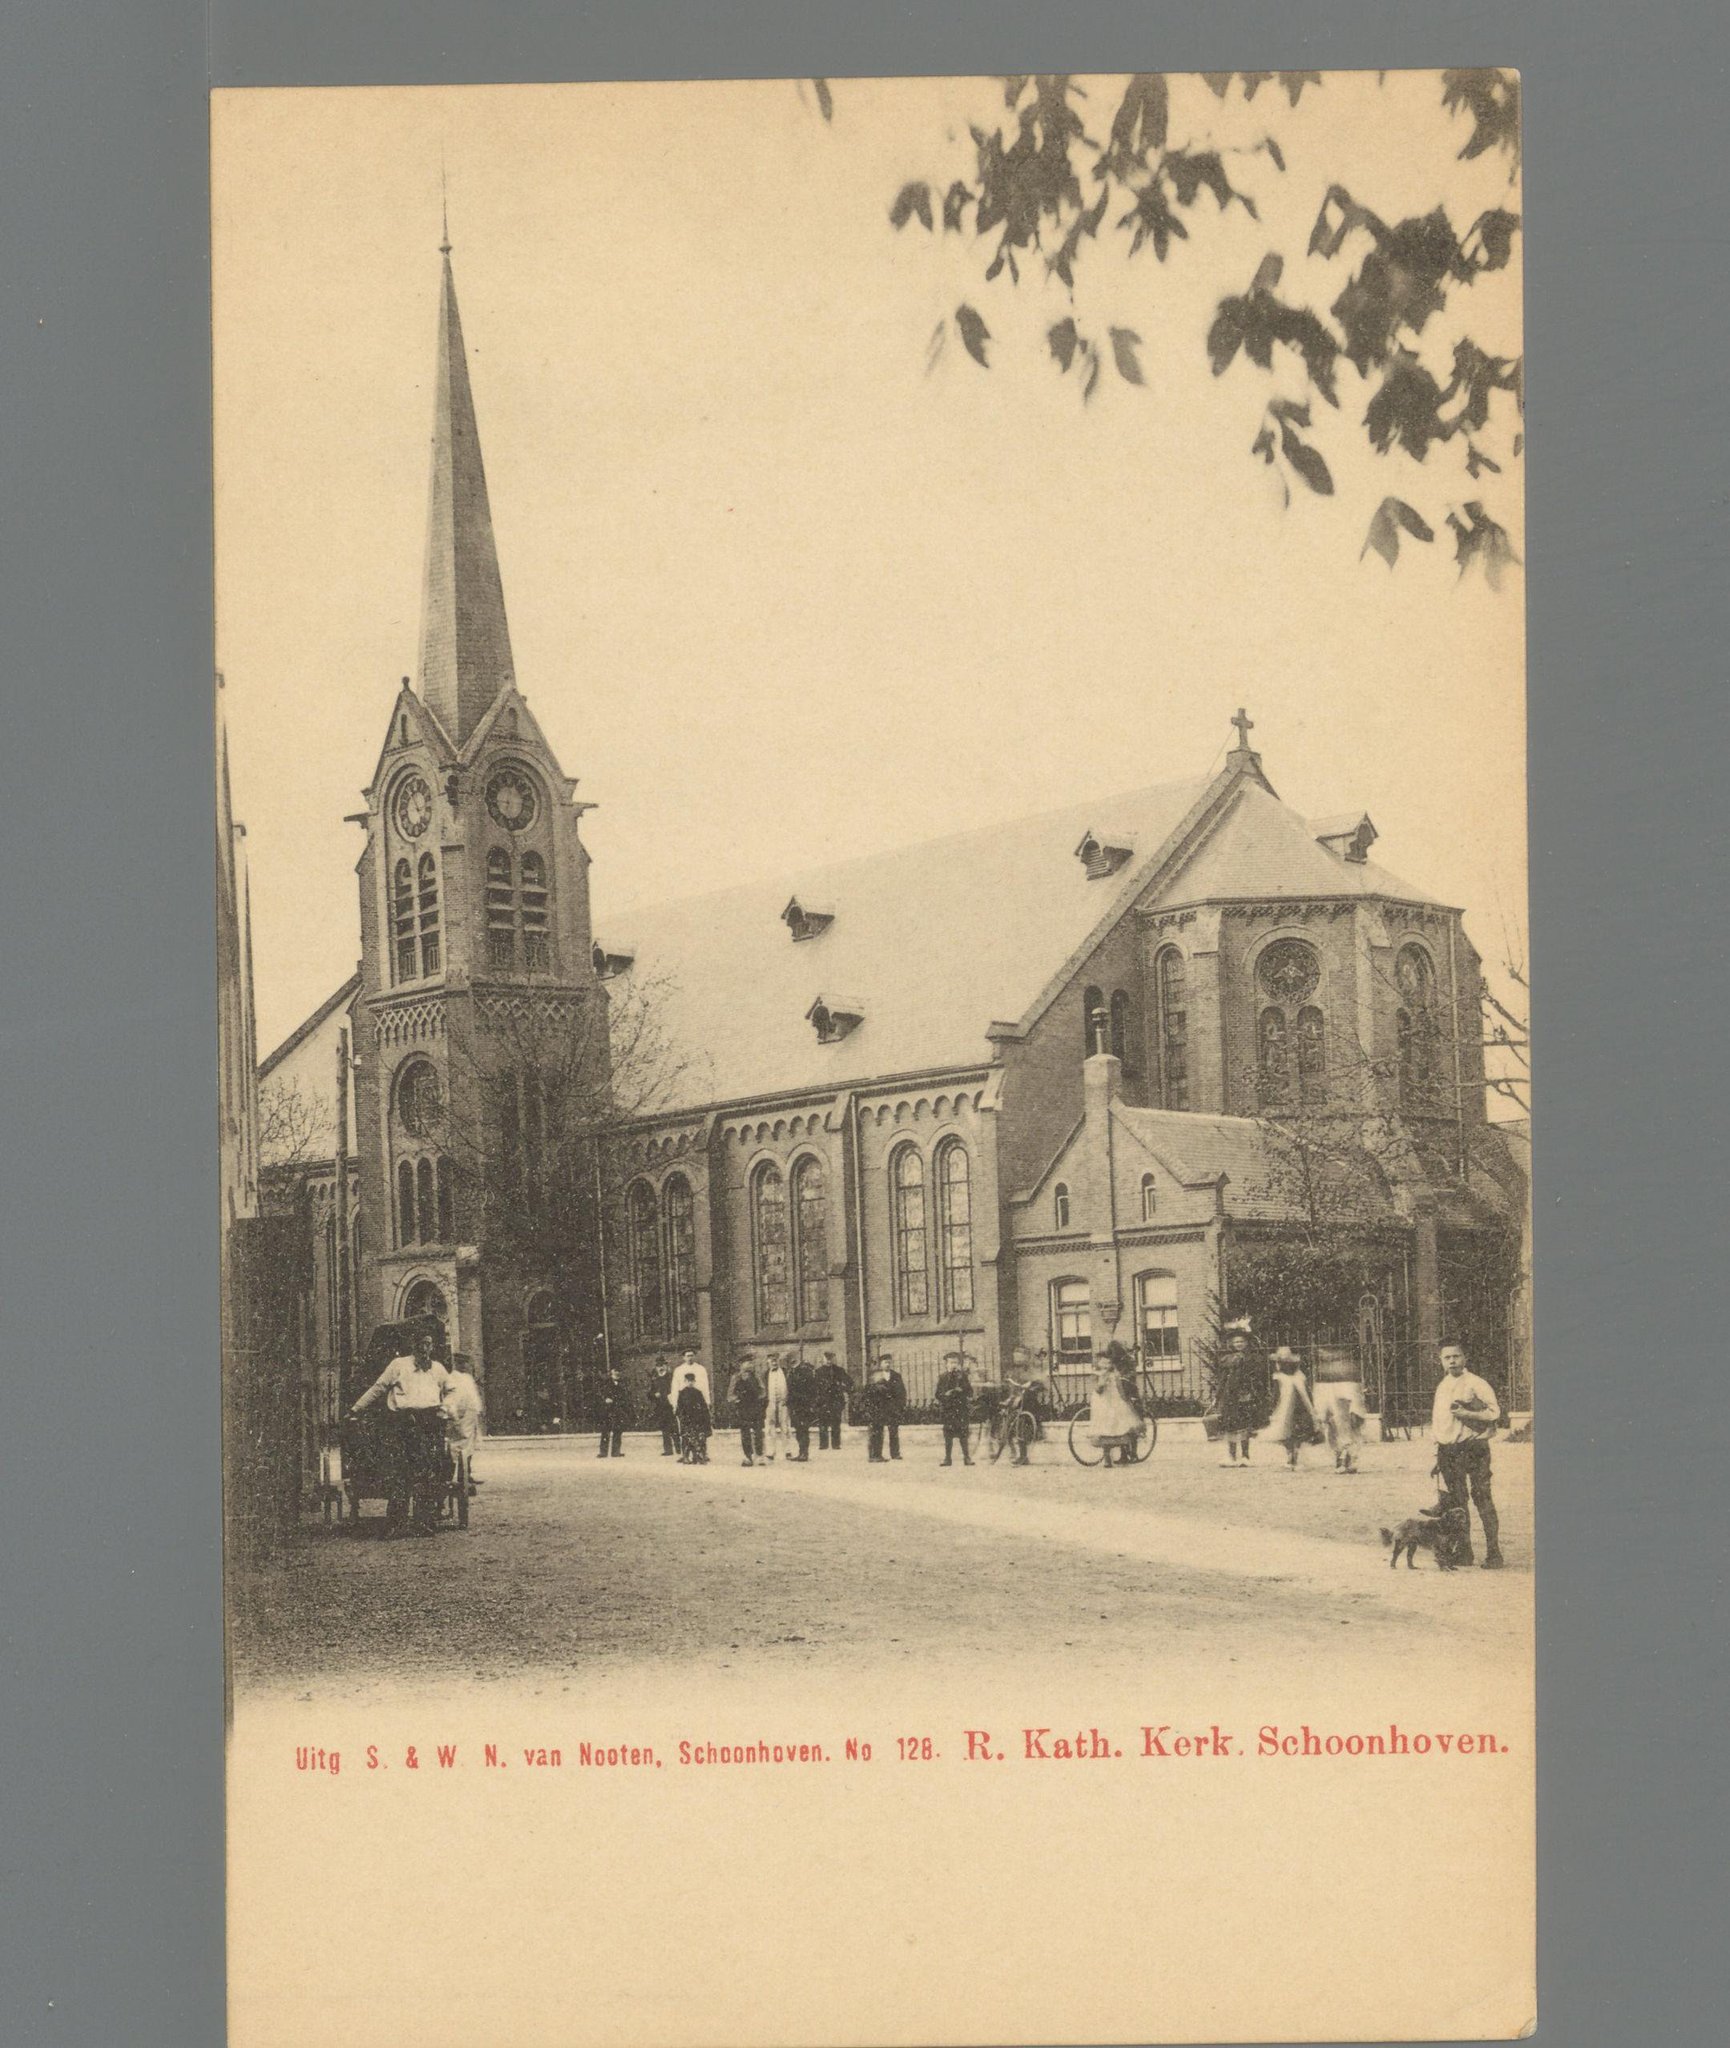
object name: ansichtkaart, prentbriefkaart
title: R. Kath. Kerk. Schoonhoven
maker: Anonymous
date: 1897-1905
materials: cardboard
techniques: photograph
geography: schoonhoven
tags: church (exterior)